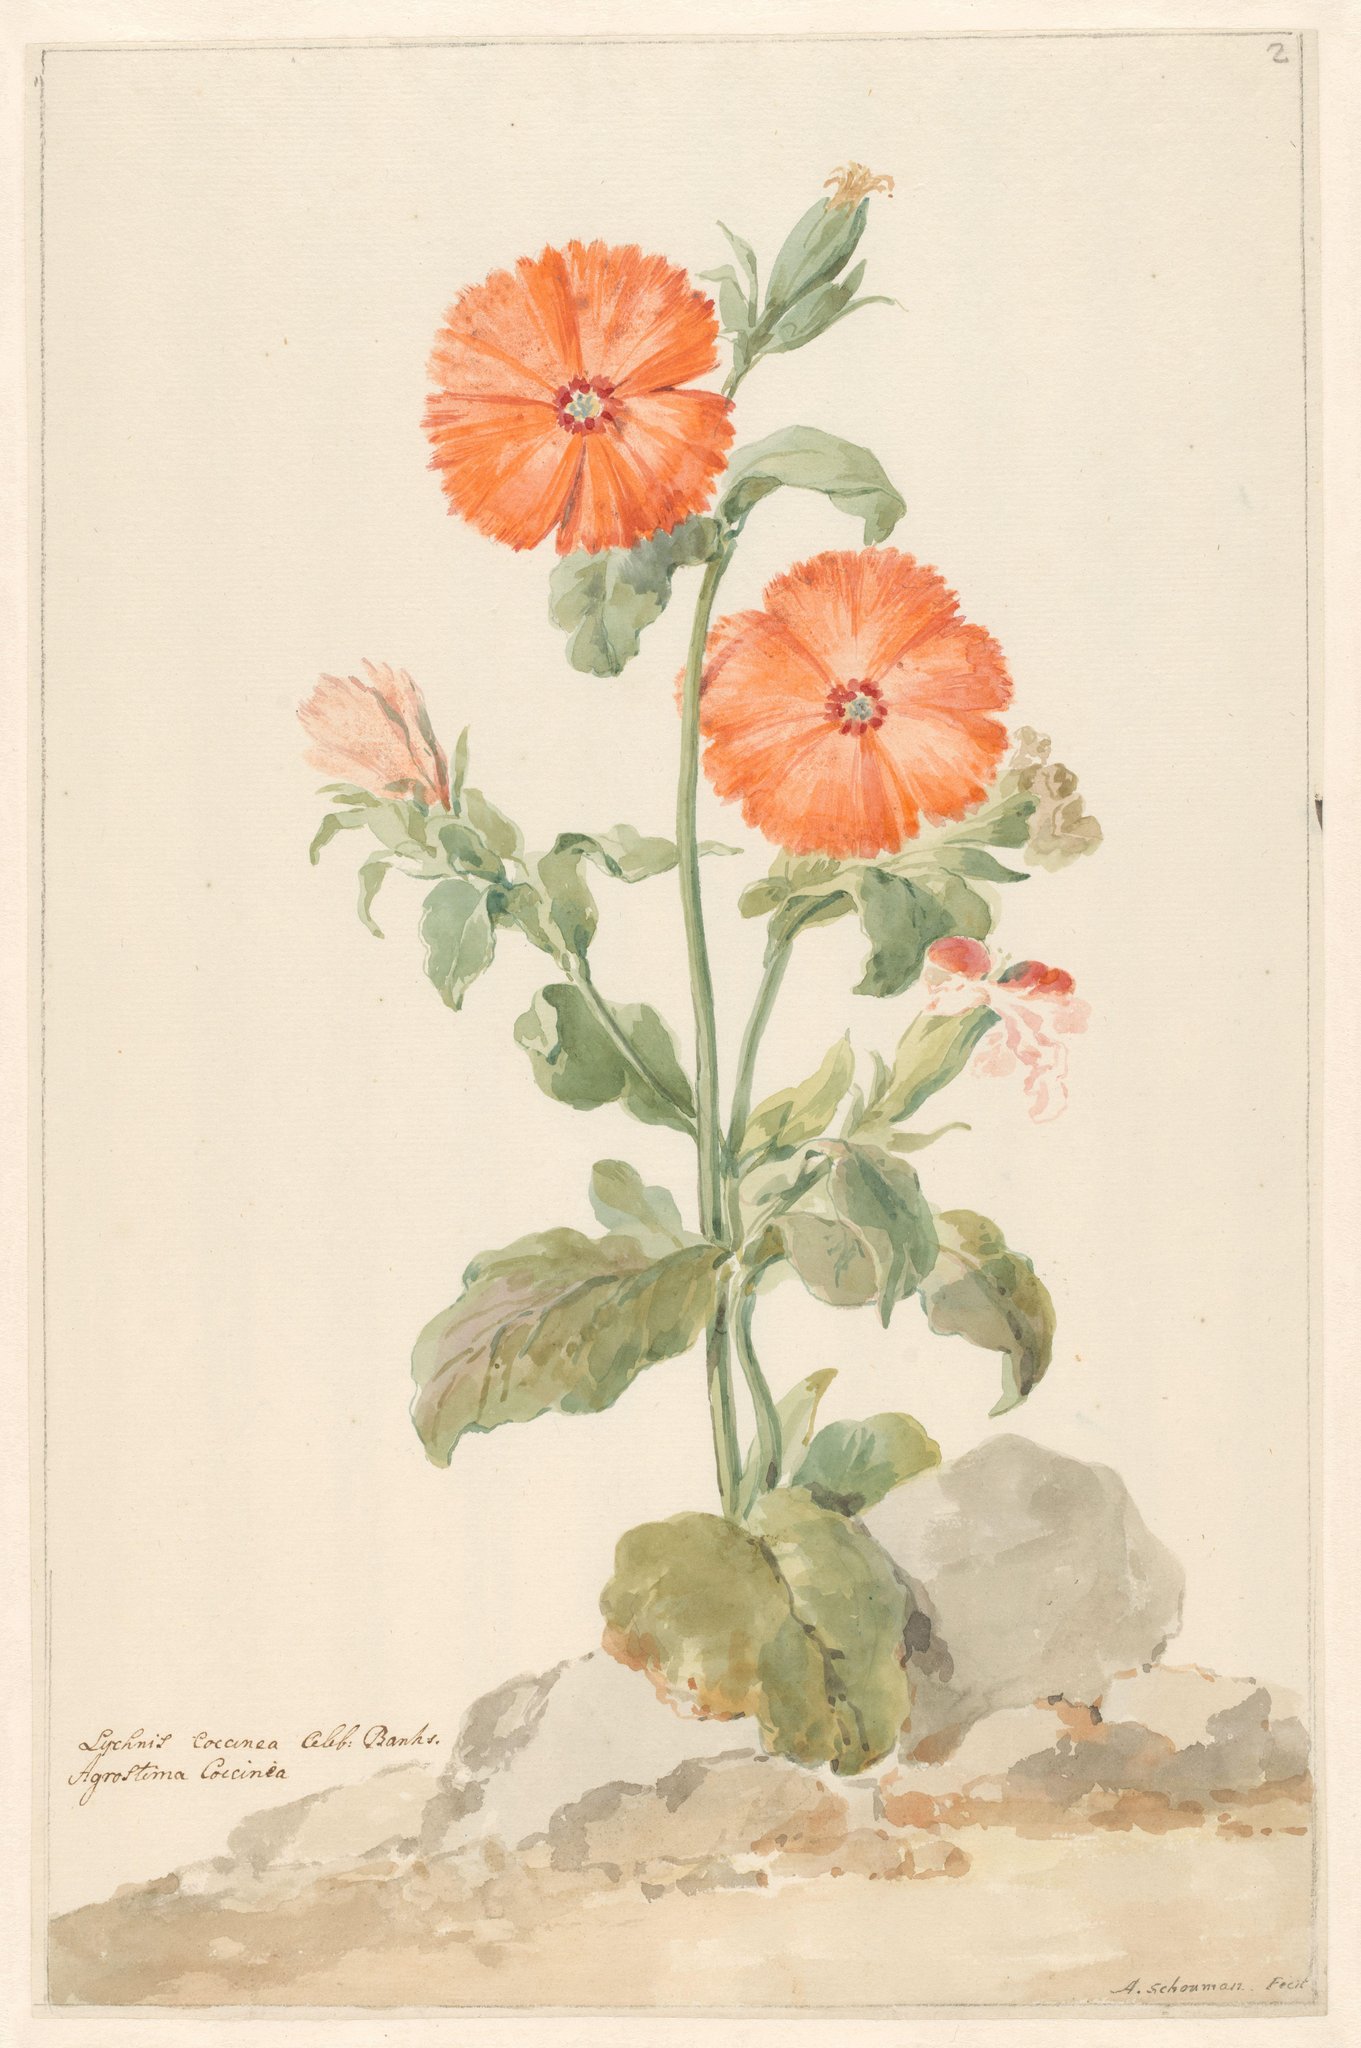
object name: drawing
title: Oranje koekoeksbloem in landschap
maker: aert schouman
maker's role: draughtsman, painter, print maker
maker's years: 1710-1792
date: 1790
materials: pencil, watercolor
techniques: brush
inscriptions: signature: ‘A. Schouman Fecit’, inscription: ‘2’, annotation: ‘Lychnis Coccinea Celeb: Banks. / Agrostima Coccinea’